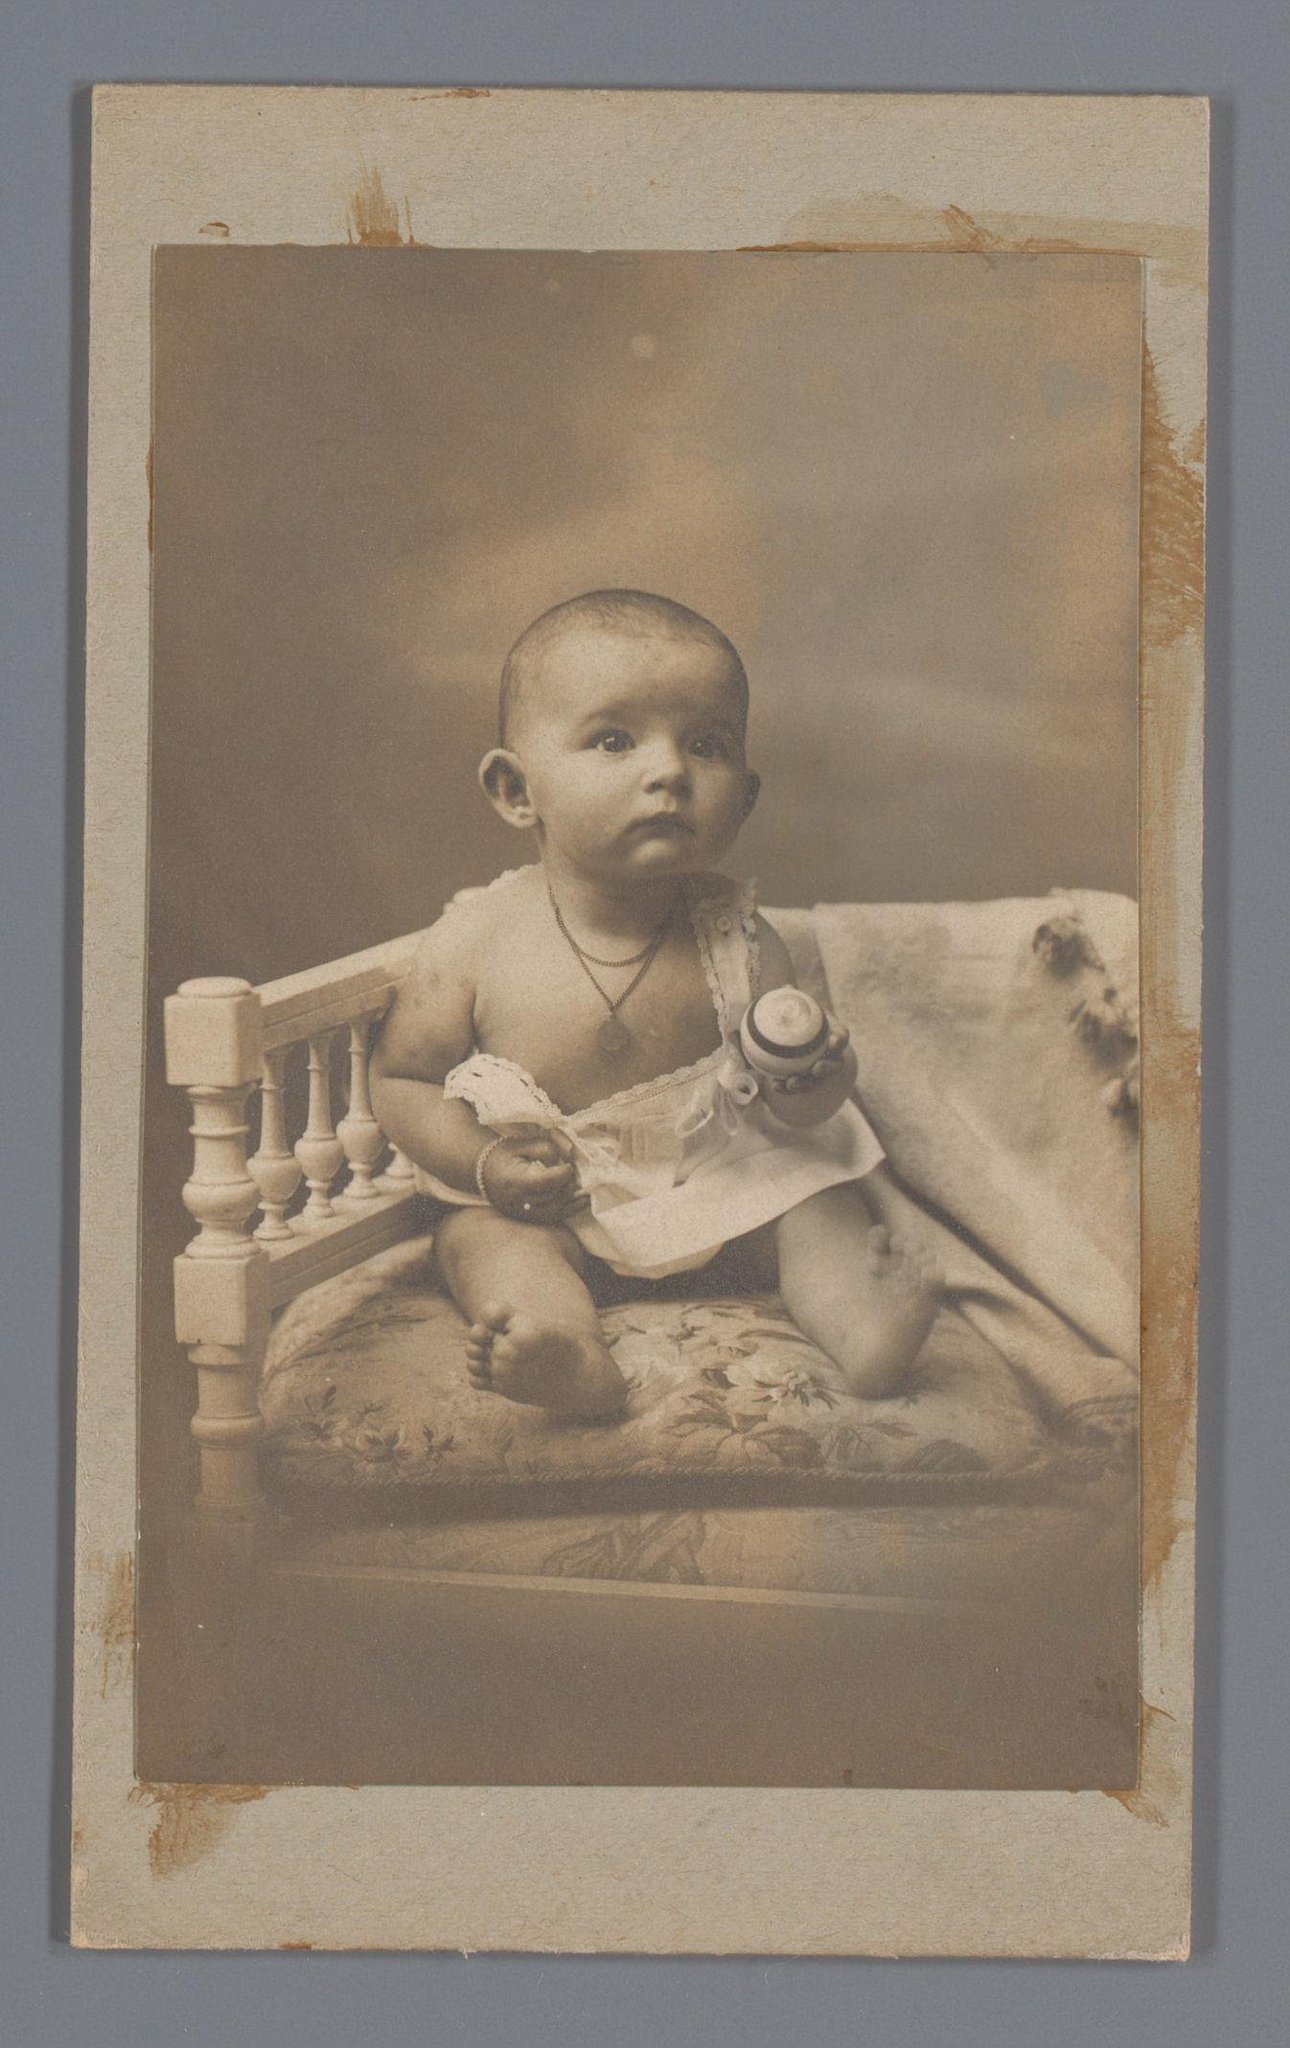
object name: photograph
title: Portret van een onbekende baby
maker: Anonymous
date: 1900-1914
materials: paper, cardboard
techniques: gelatin silver print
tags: anonymous historical person portrayed, infant, baby